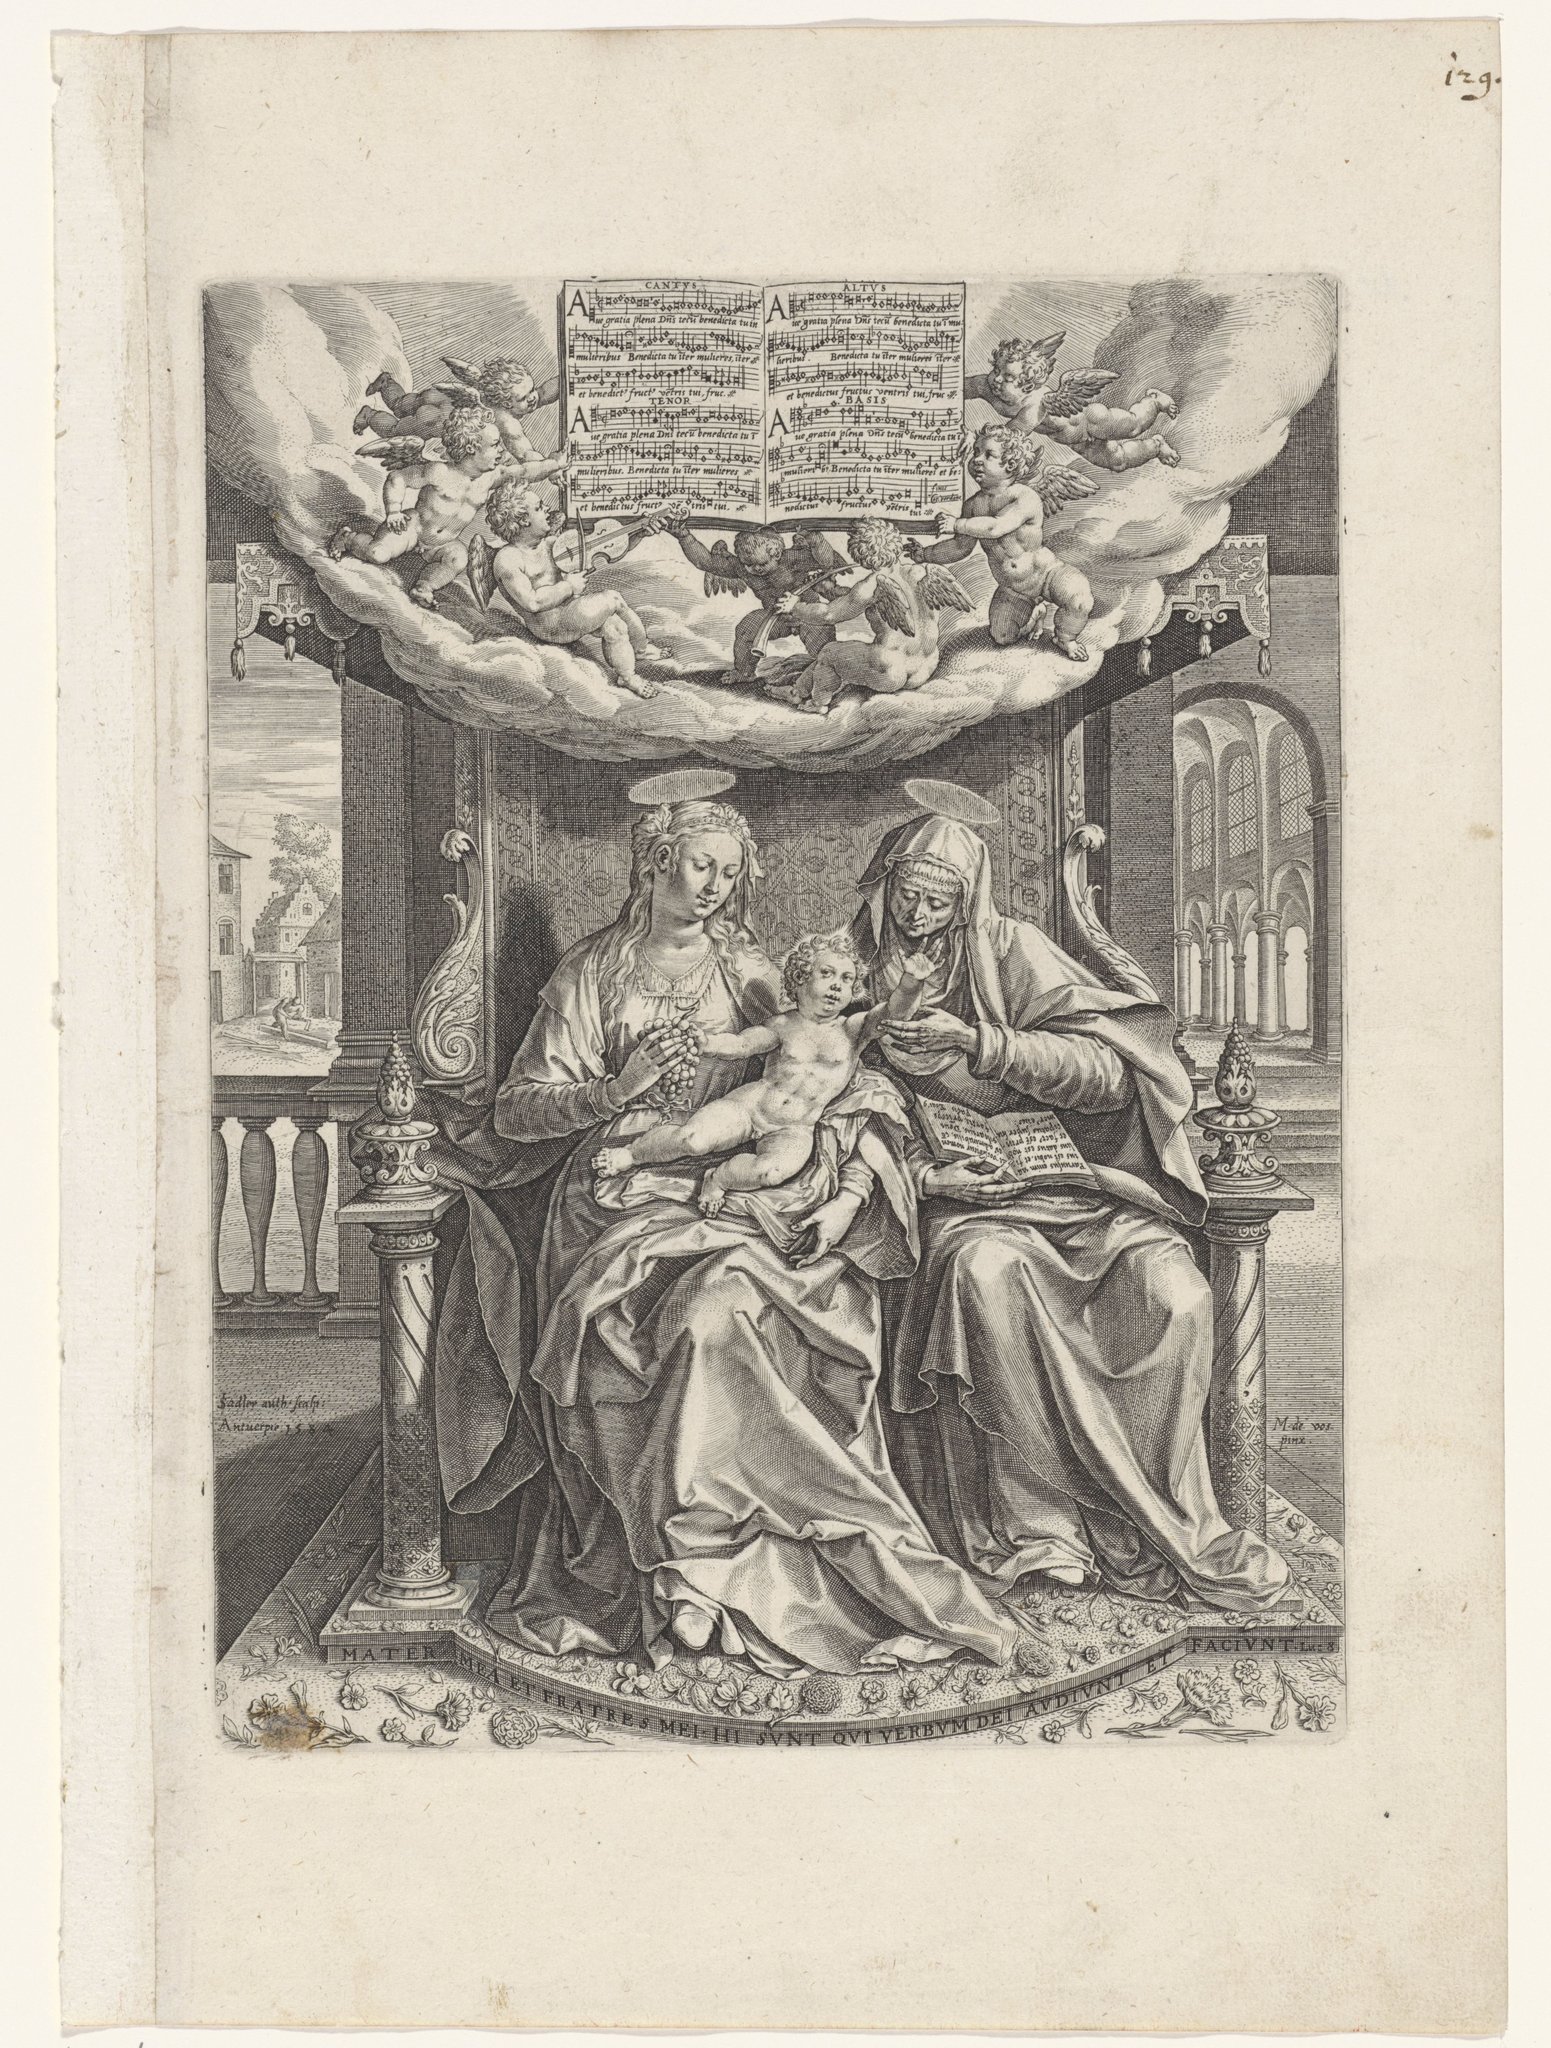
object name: beeldmotet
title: Anna-te Drieën met het motet 'Ave gratia plena'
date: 1584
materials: paper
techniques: engraving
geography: antwerp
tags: angels singing, making music, printed edition of musical score, still other arrangements of 'anna selbdritt', e.g.: young john the baptist present, isaiah's prophecy of the birth of christ ('immanuel') (possibly with mary, the angel gabriel and king ahaz) (isaiah 7:14-16)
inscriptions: collector's mark: Lugt 2228, number: ‘ir.9’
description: Maria met Kind en de H. Anna, zittend op een troon met baldakijn. Het Kind zit op de schoot van Maria, die een druiventros in haar rechterhand houdt. Op de schoot van de H. Anna een bijbel, openliggend bij de tekst van Jesaja 9.6, waarin de geboorte van Christus wordt aangekondigd. Boven de troon in een wolk vijf engeltjes die een open muziekboek vasthouden waarin muzieknotatie van het vierstemmige motet 'Ave gratia plena' van Cornelis Verdonck. Twee engeltjes die de zink en de viola da braccio bespelen. Op de rand van de troon citaat uit Lukas 1: MATER MEA ET FRATRES MEI HI SUNT, QUI VERBUM DEI AUDIUNT ET FACIUNT.